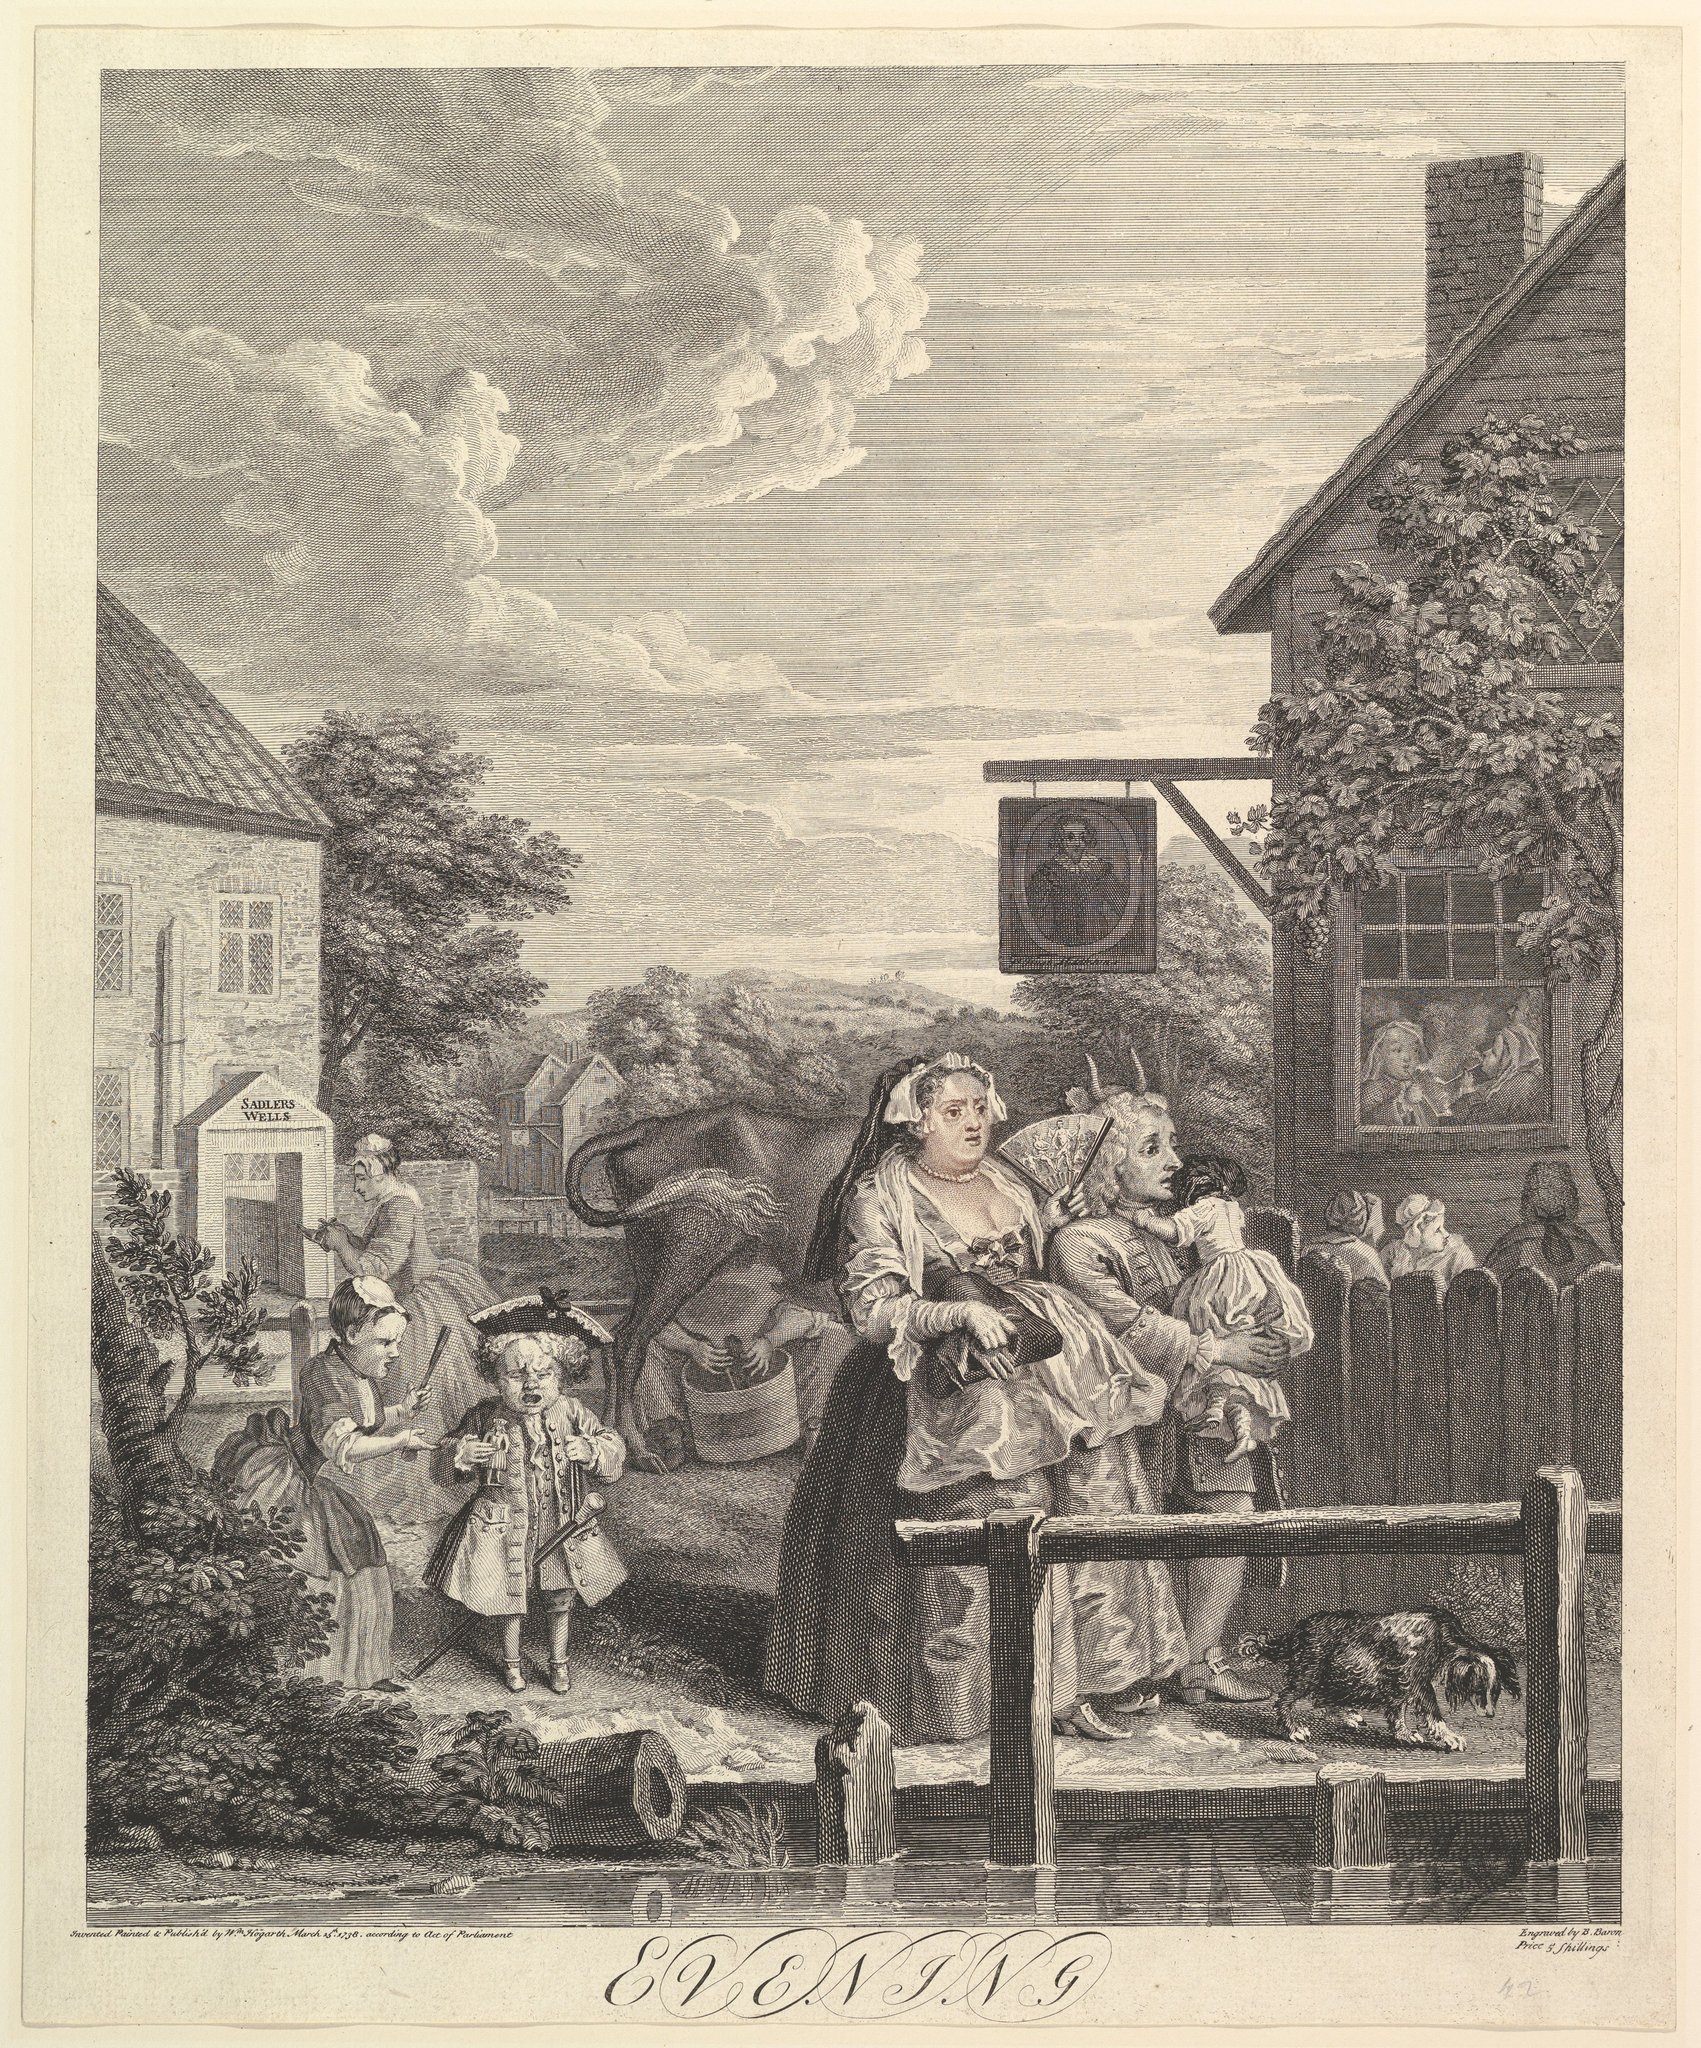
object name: print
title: Evening: The Four Times of Day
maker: bernard baron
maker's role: engraver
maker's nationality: french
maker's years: 1696-1762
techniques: engraving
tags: children,women,cows,dogs